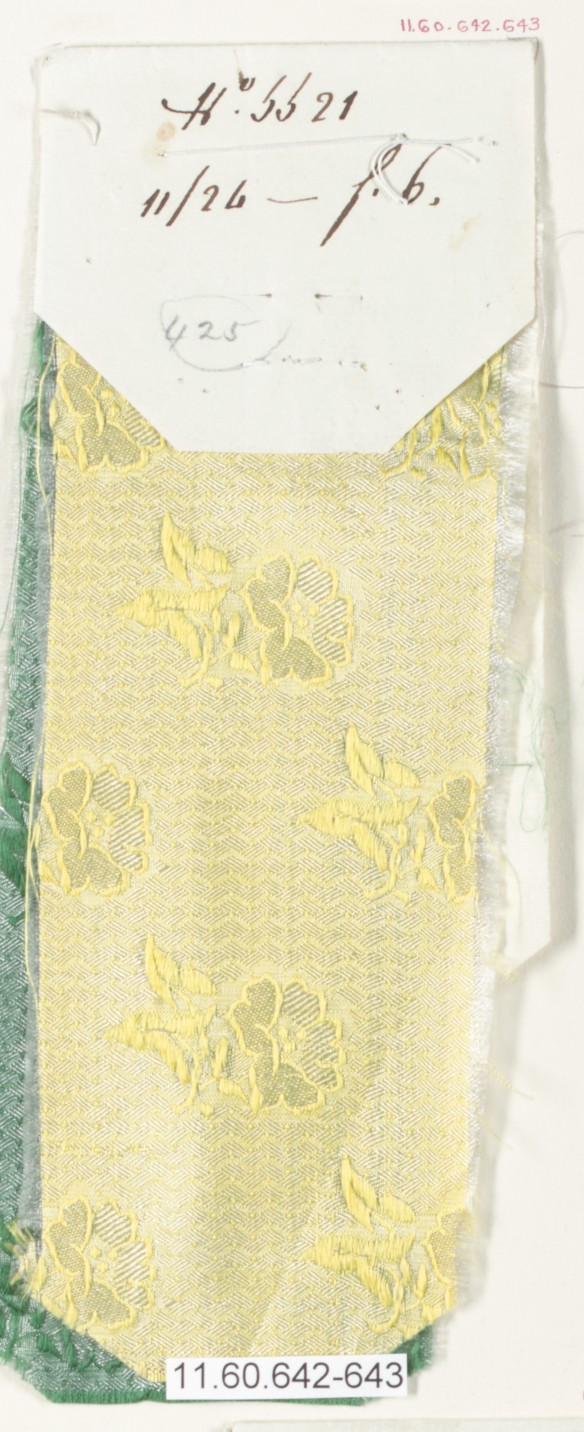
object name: sample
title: Samples (2)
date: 1801-1833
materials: silk